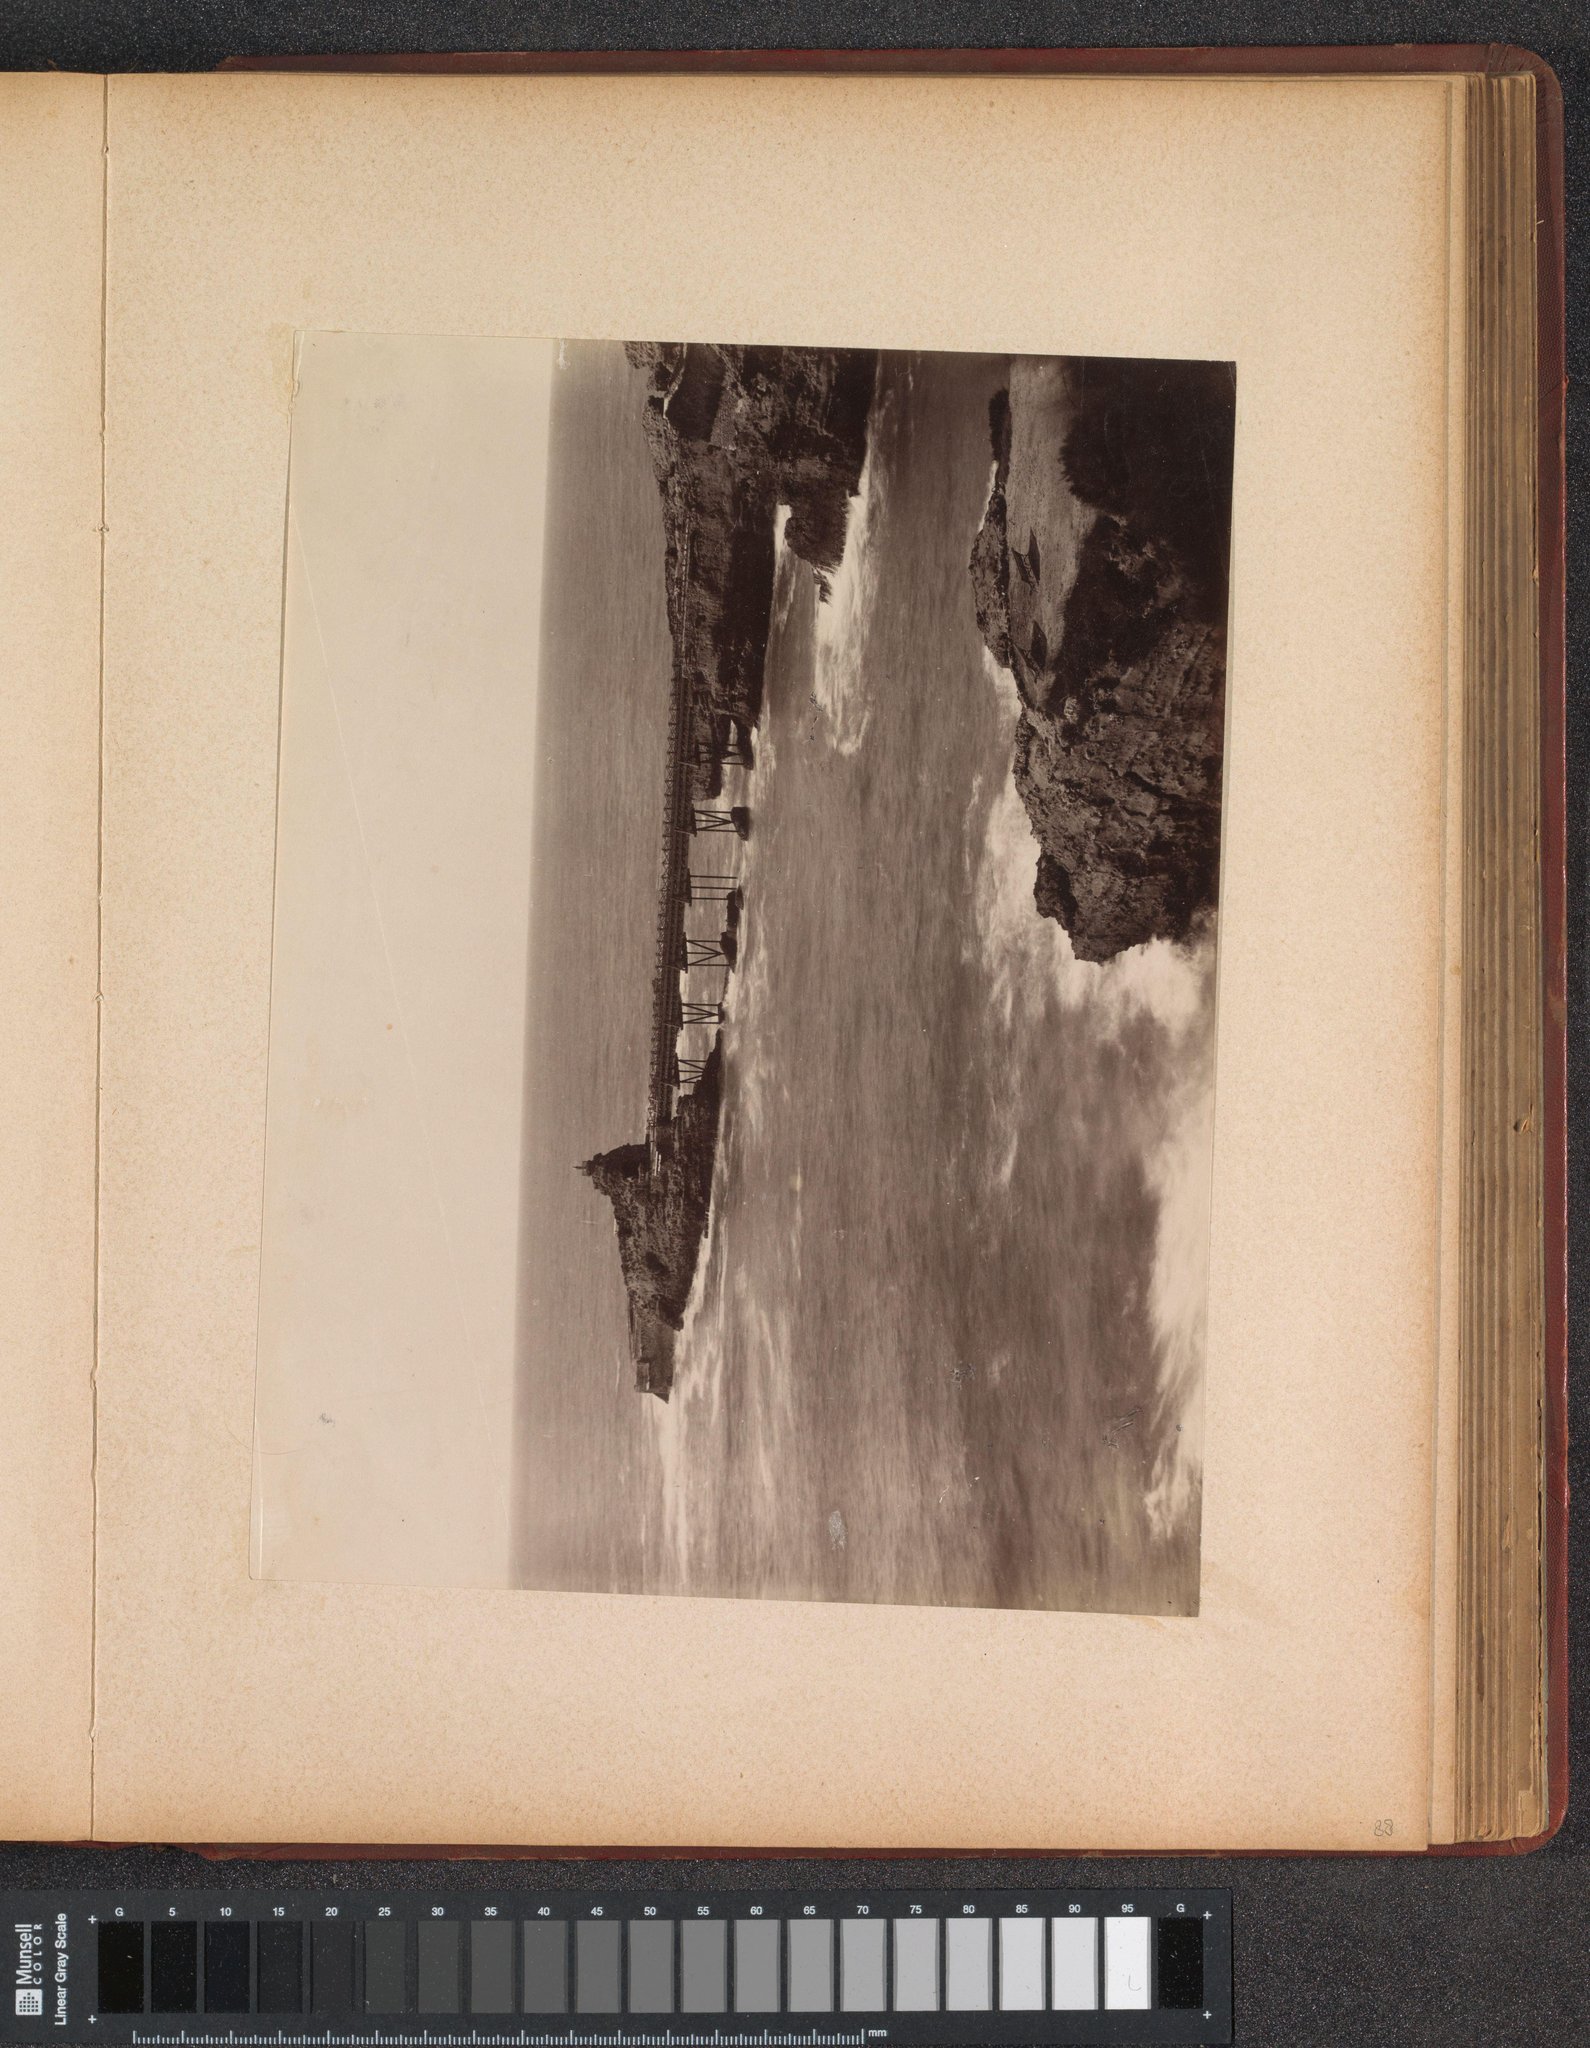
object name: album leaf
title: Gezicht op een brug tussen rotsen, vermoedelijk aan de kust bij Monaco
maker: jean gilletta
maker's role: fotograaf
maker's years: 1856-1933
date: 1870-1900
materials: paper, photographic support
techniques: albumen print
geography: monaco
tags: landscape with bridge, viaduct or aqueduct, rocks (+ landscape with figures, staffage), coast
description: Onderdeel van Reisalbum met foto's van bezienswaardigheden in Italië en Zuid-Frankrijk.